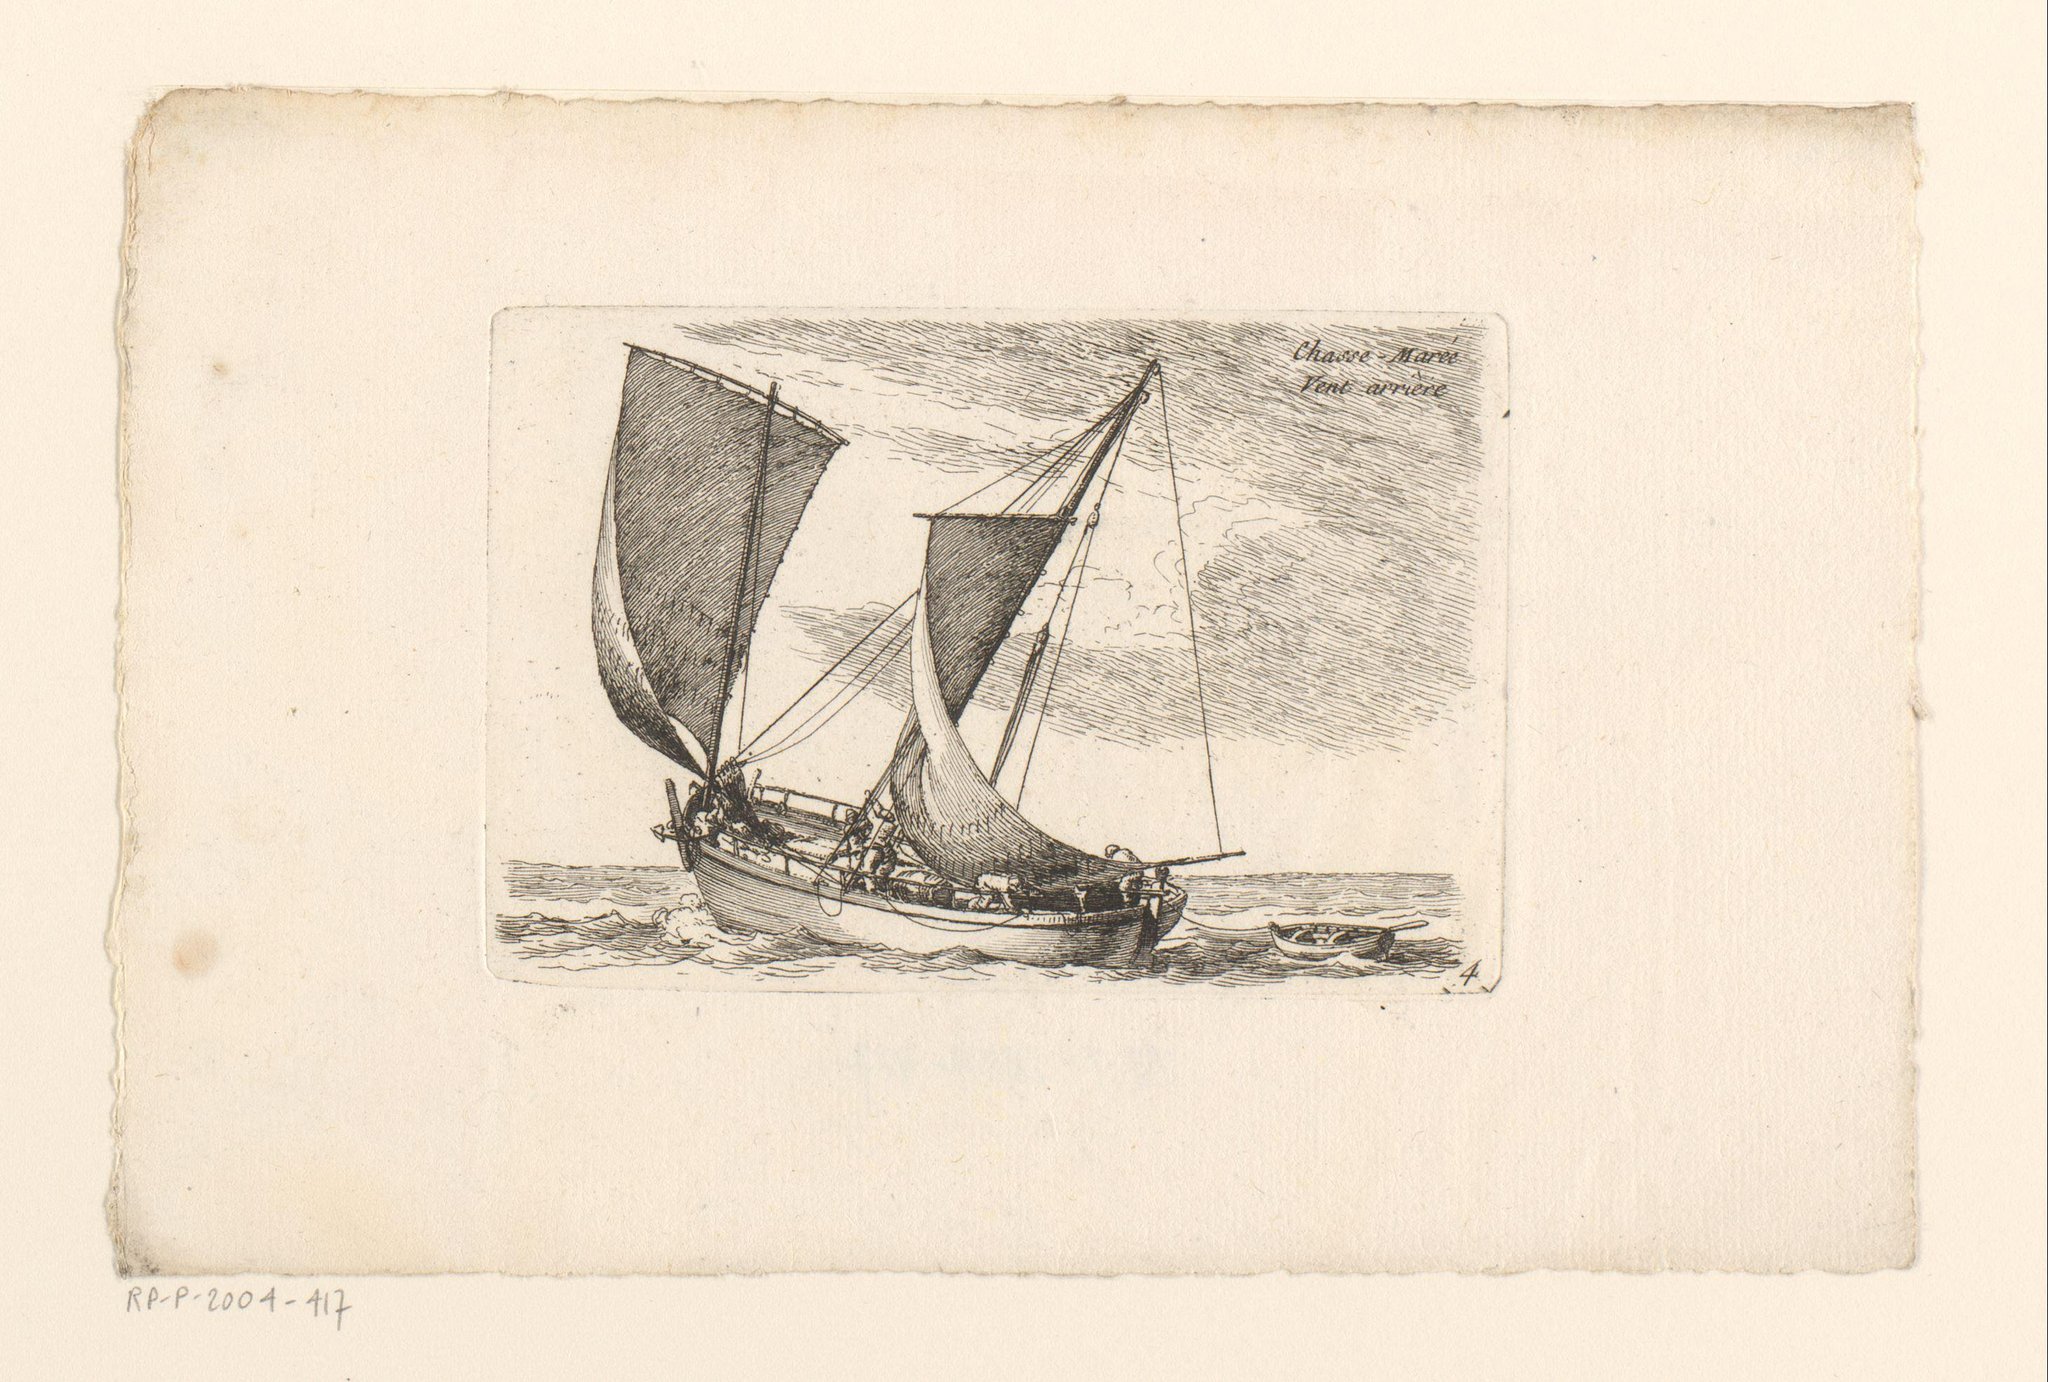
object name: print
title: Chasse Marée Vent arrière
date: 1738-1811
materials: paper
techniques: etching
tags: sailing-ship, sailing-boat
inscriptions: collector's mark: Lugt 2228, collector's mark: Lugt 2760